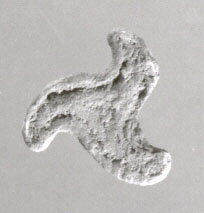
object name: stamp seal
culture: bactria-margiana archaeological complex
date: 2333-1668 BCE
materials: copper alloy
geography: bactria-margiana